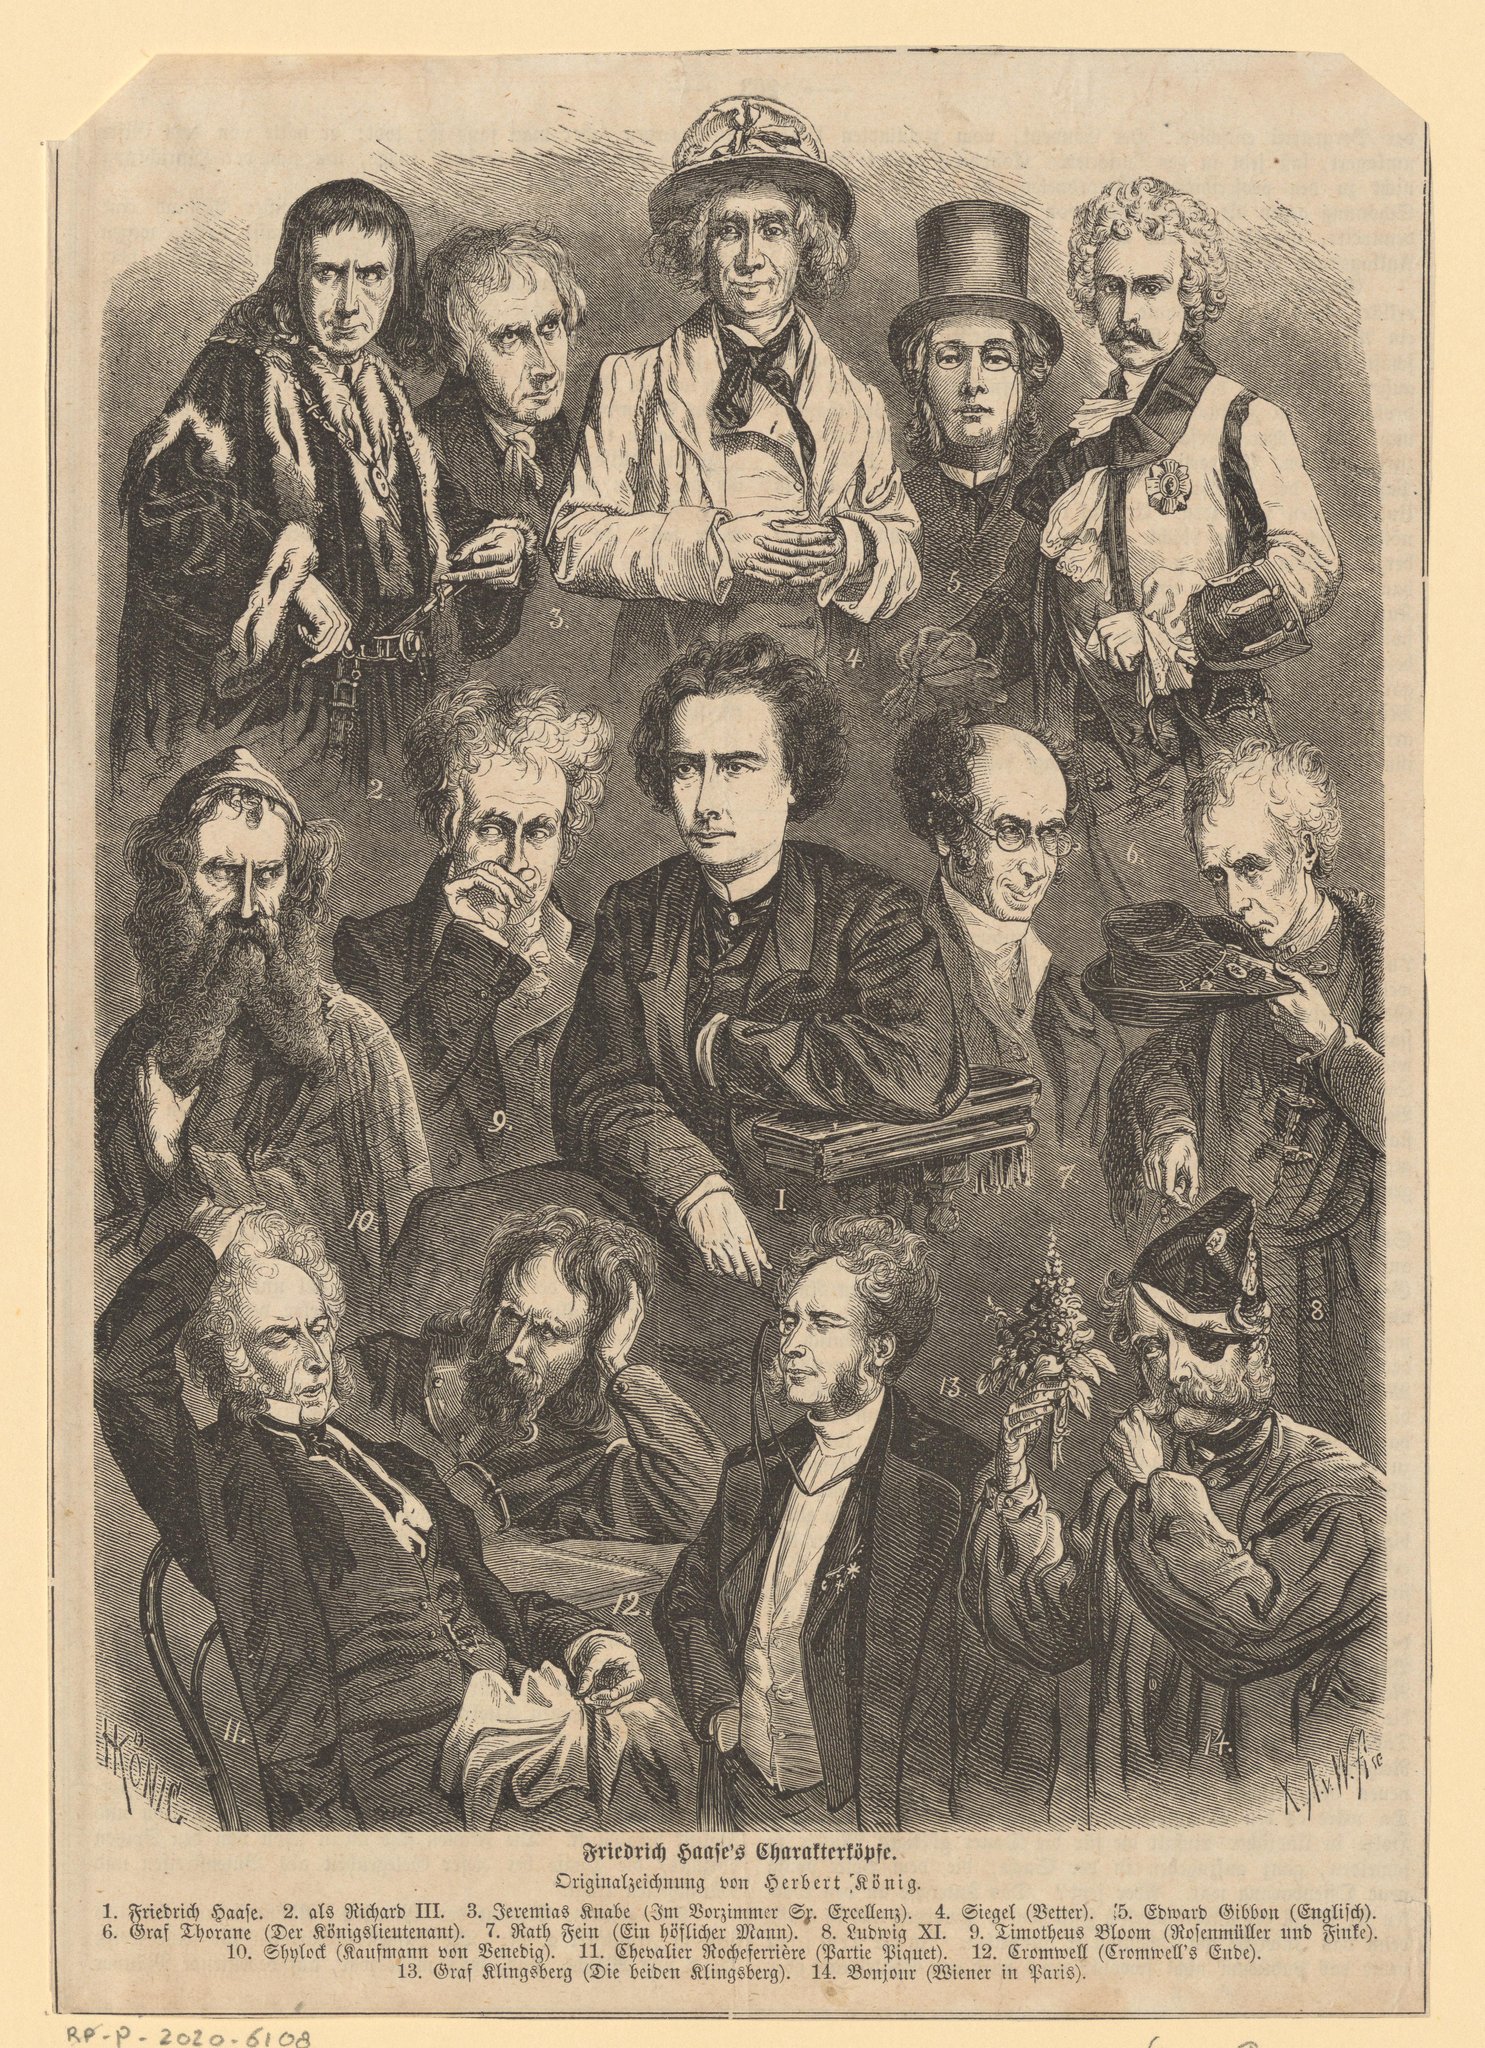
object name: print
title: Portret van Friedrich Haase, omringd door dertien portretten van verschillende rollen die hij vertolkte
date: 1866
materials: paper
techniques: letterpress printing, engraving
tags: historical persons, portrait of actor, actress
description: De rollen die Friedrich Haase vertolkte en hier zijn afgebeeld bestaan onder andere uit: Richard III van Engeland, Edward Gibbon, Lodewijk XI van Frankrijk en Thomas Cromwell. Bij de fictieve personages wordt vaak het toneelstuk vermeld.